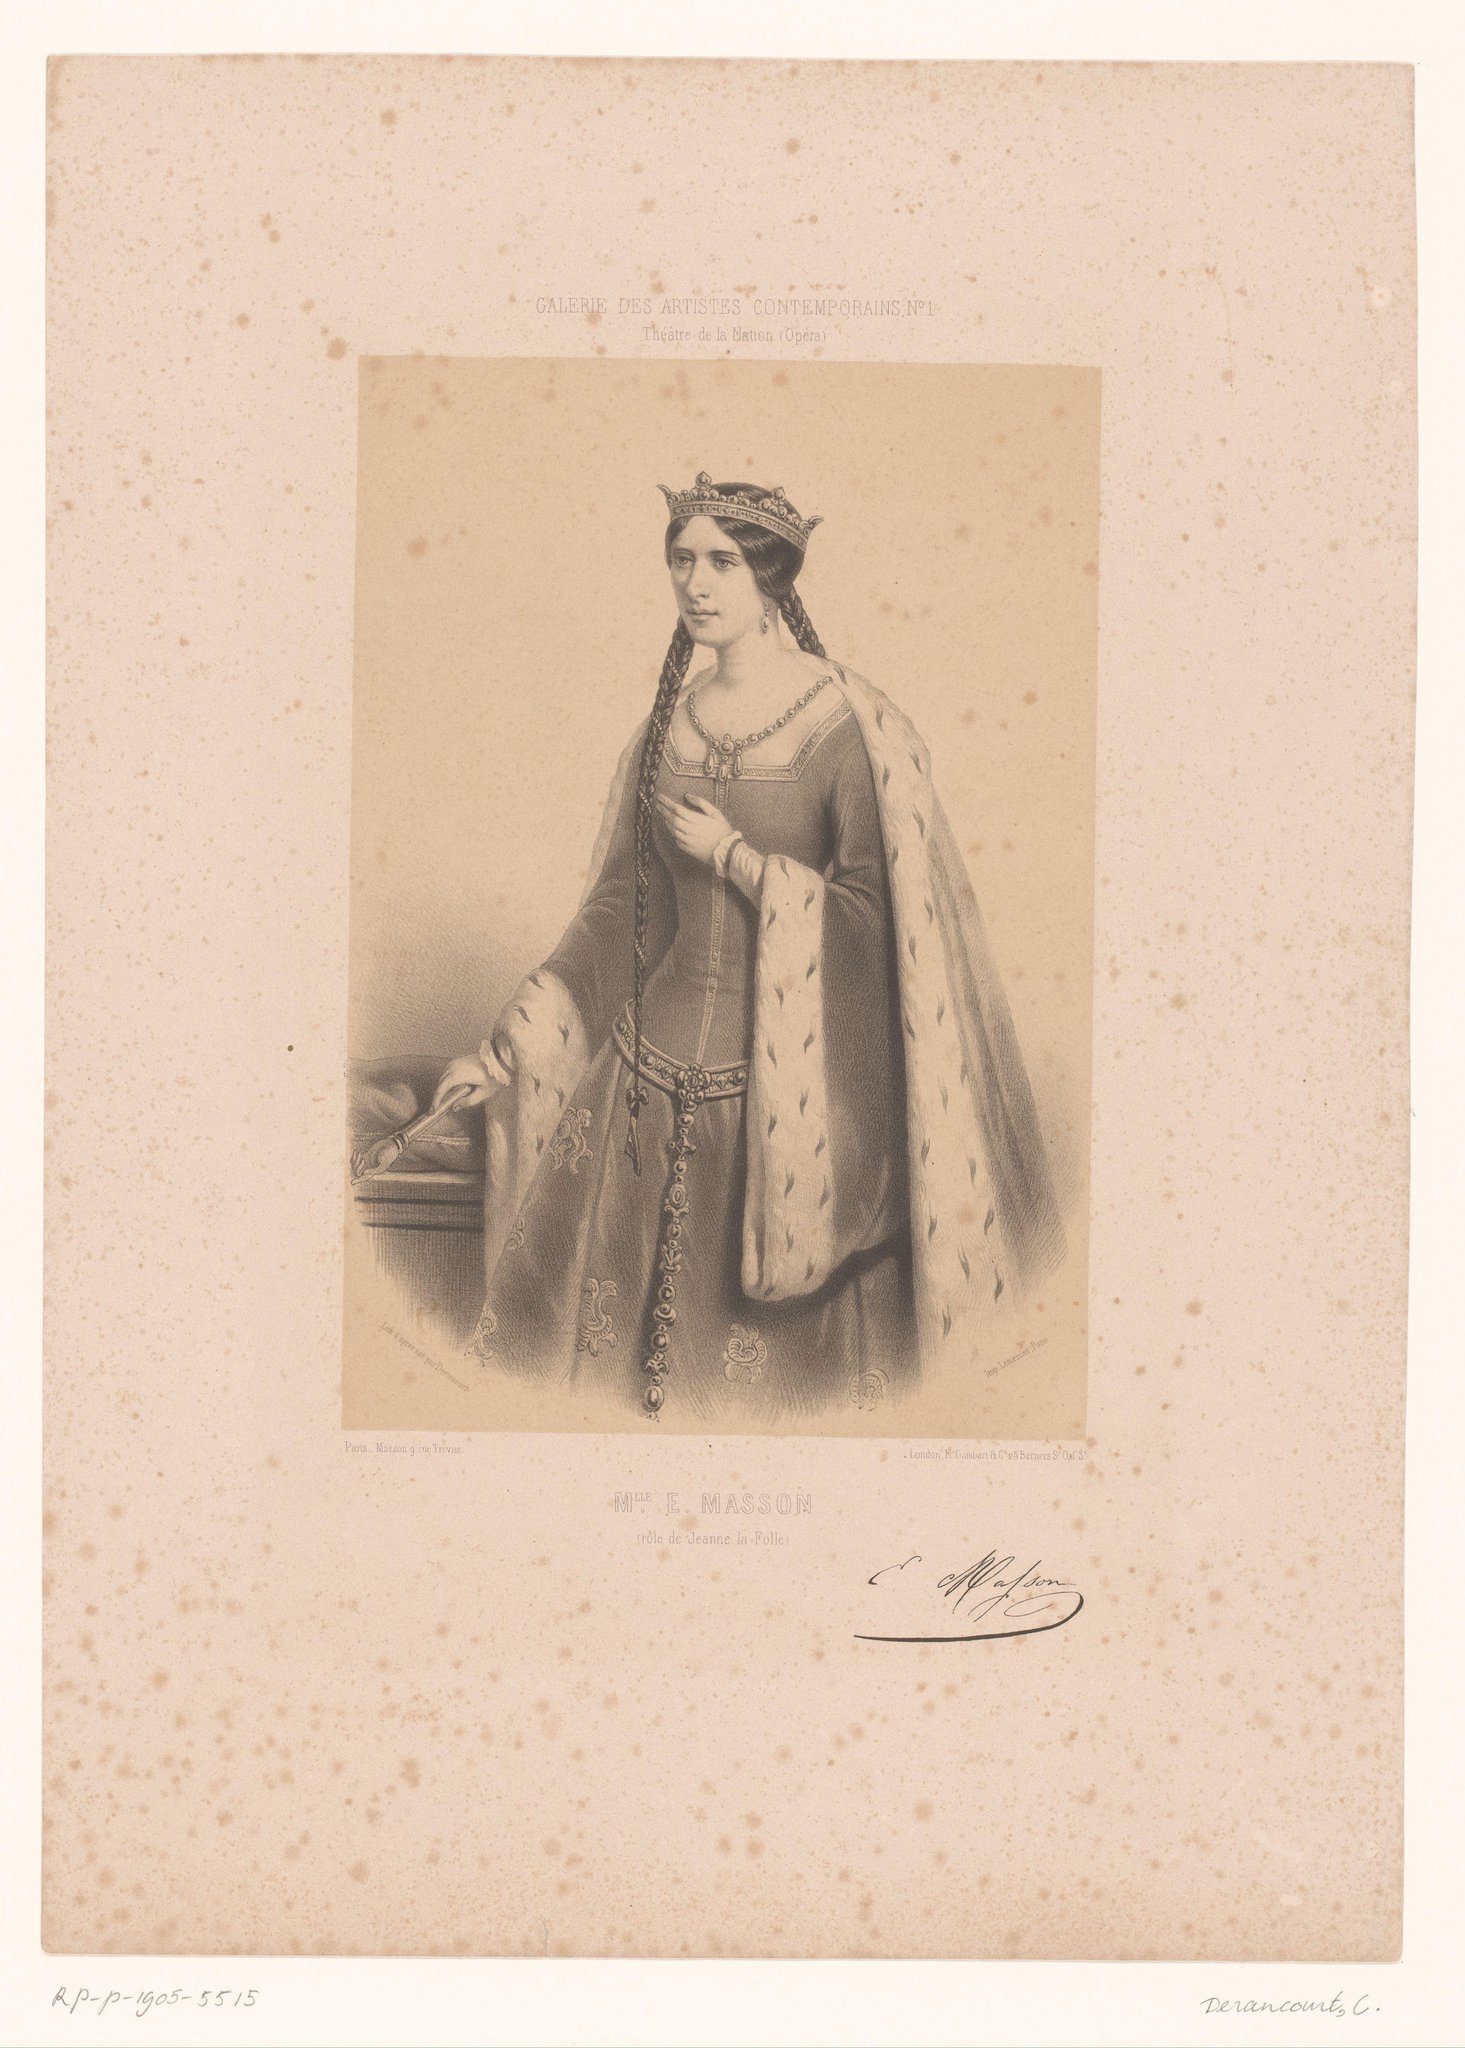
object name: print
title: Galerie des Artistes Contemporains. Théâtre de la Nation (Opéra)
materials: paper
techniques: tone lithography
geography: paris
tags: historical persons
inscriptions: collector's mark: Lugt 2228a